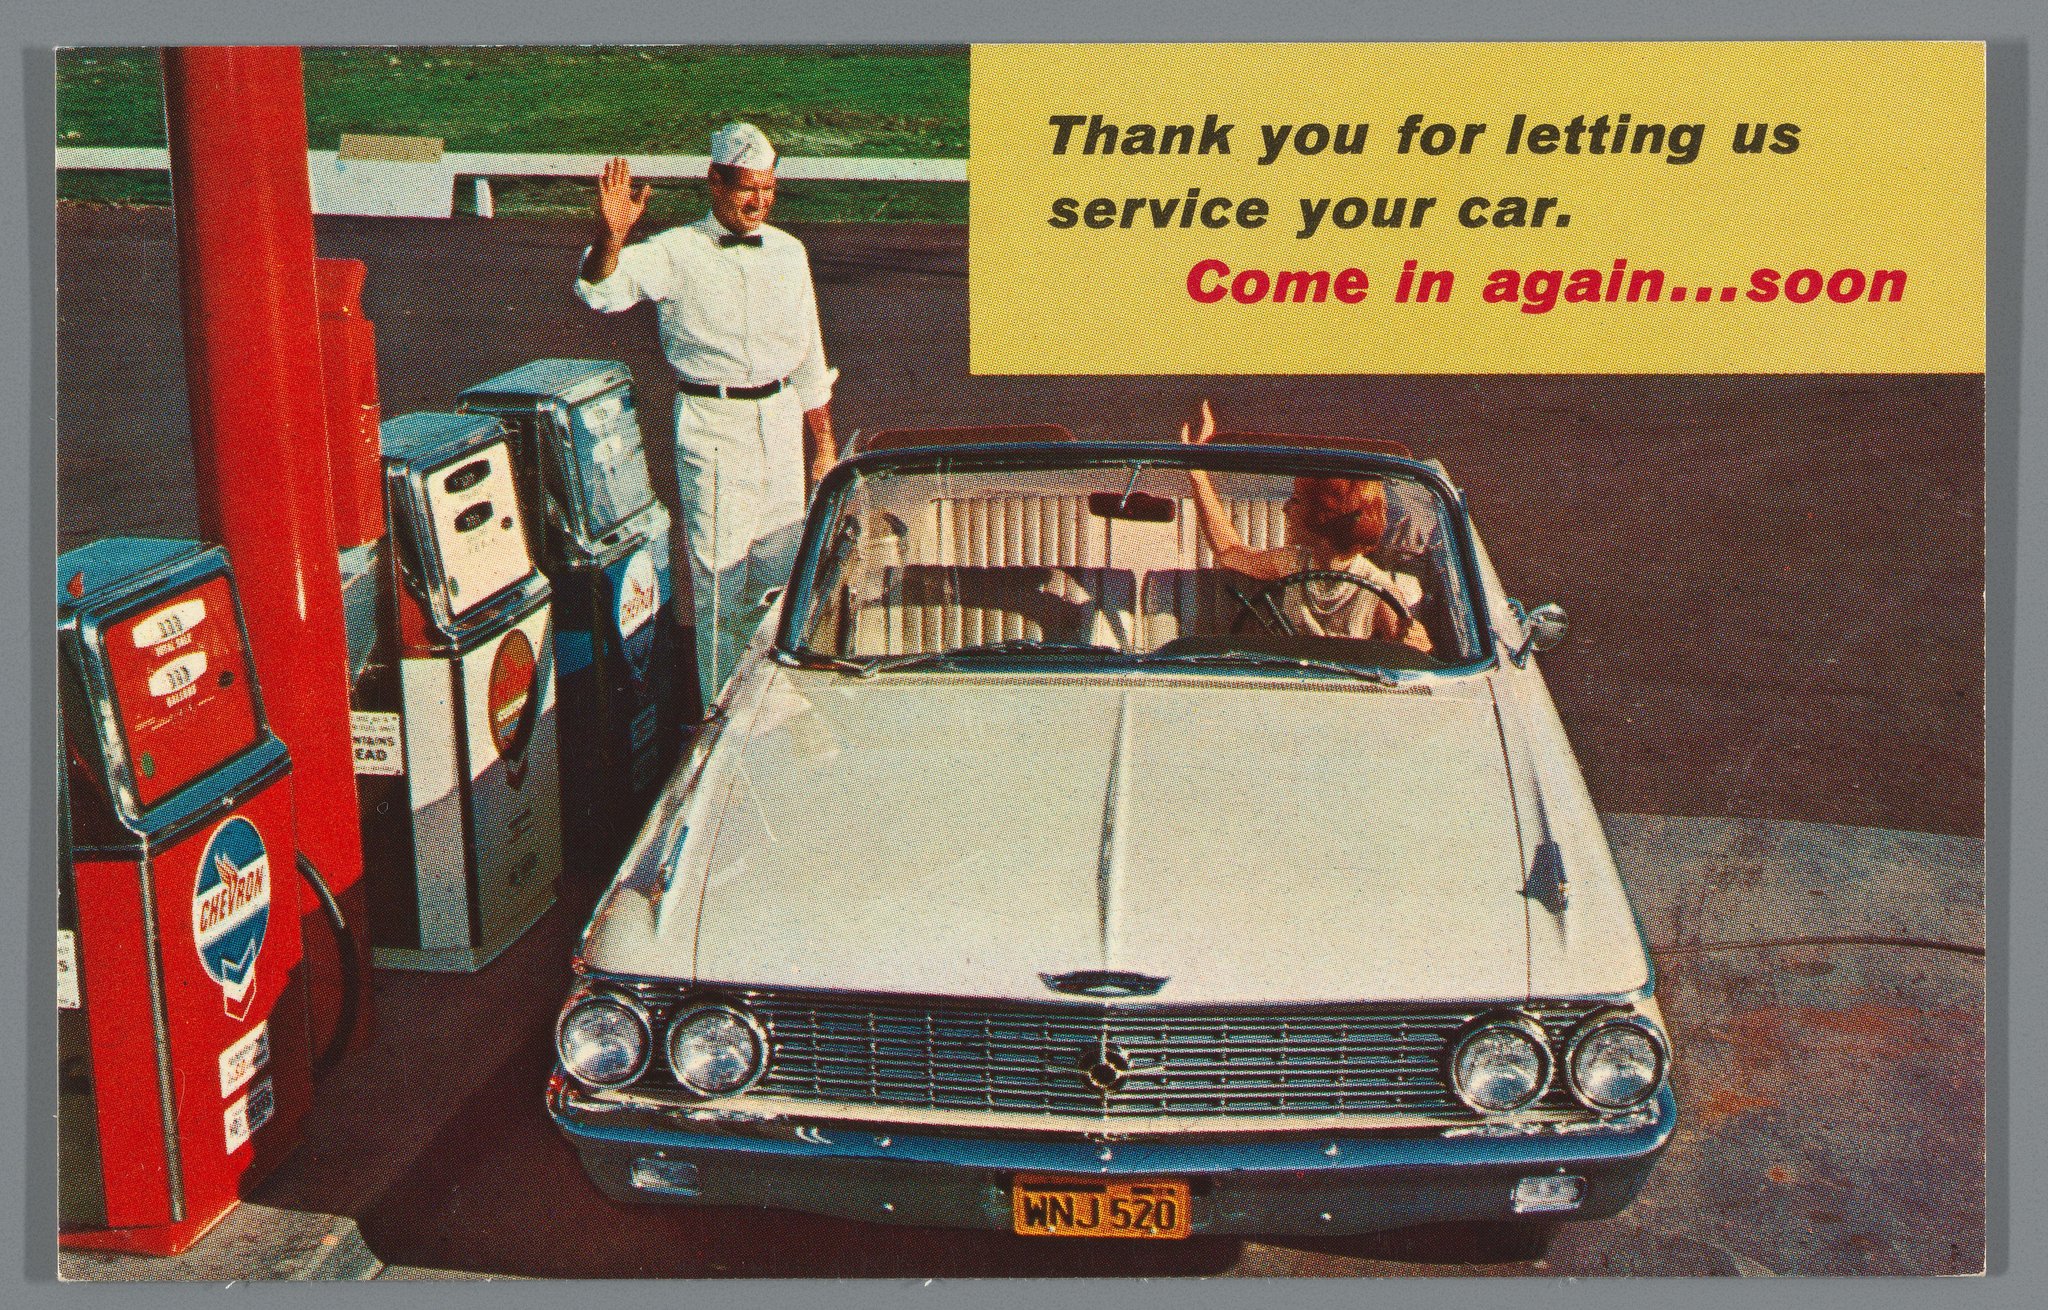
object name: ansichtkaart, prentbriefkaart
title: Thank you for letting us service your car. Come in again …soon’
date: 1955-1960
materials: paper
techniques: offset printed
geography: united states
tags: united states of america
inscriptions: inscription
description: Servicekaart in de vorm van prentbriefkaart.